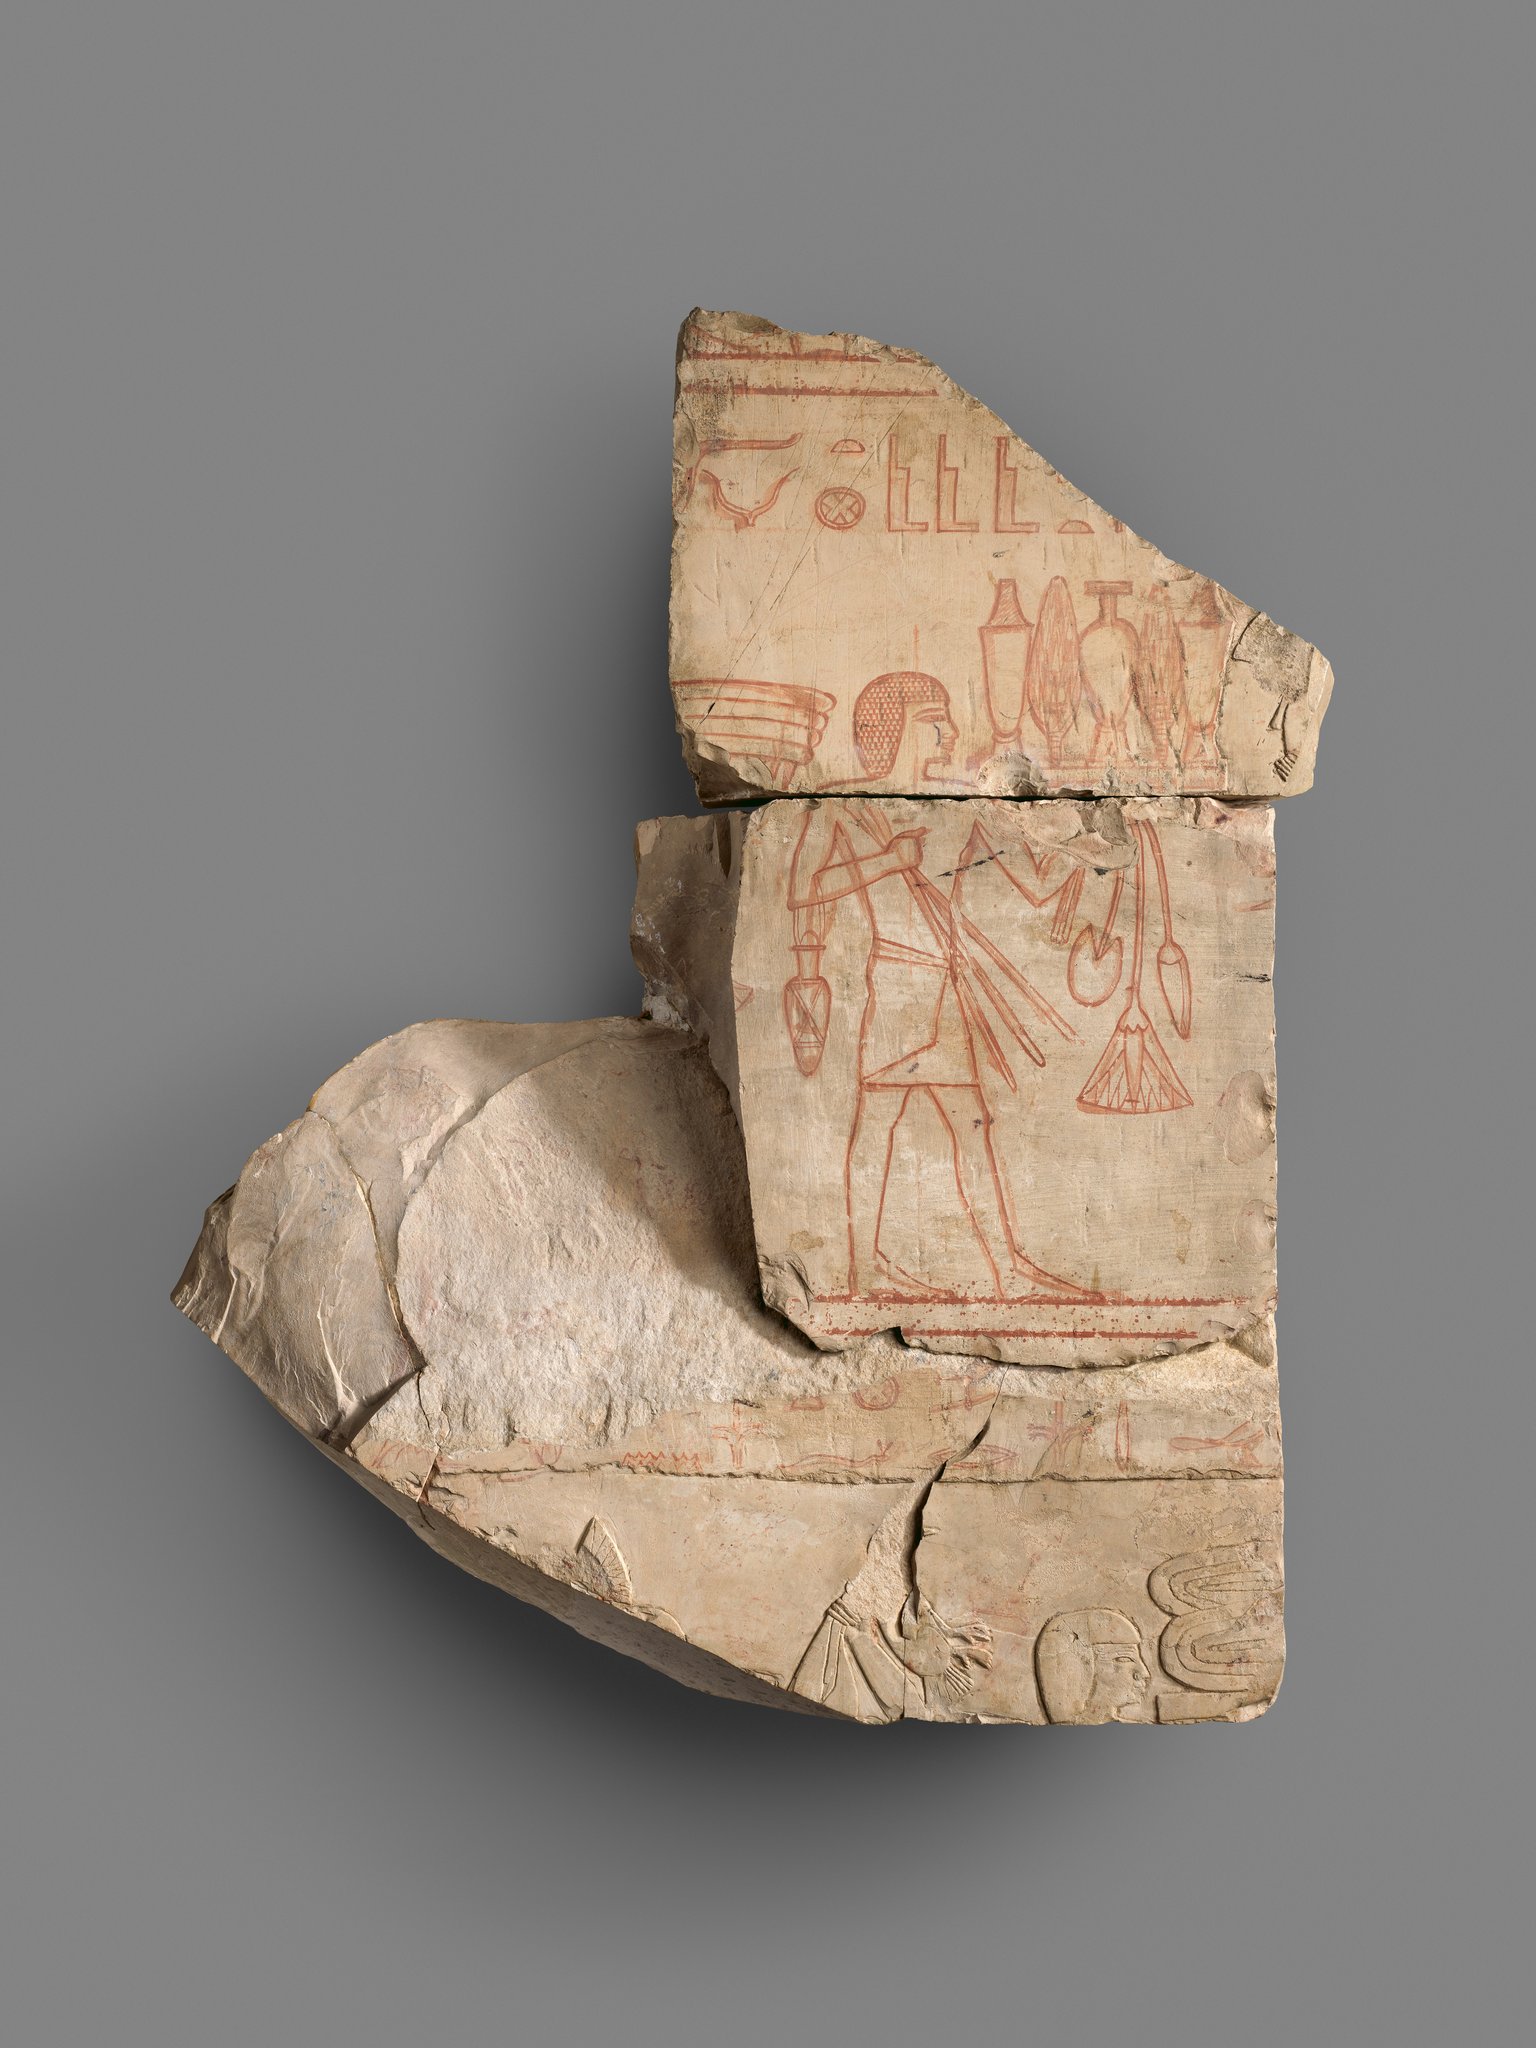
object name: relief, tomb of nespekashuty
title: Reliefs from the Tomb of Nespekashuty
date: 664-610 BCE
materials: limestone, paint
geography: egypt